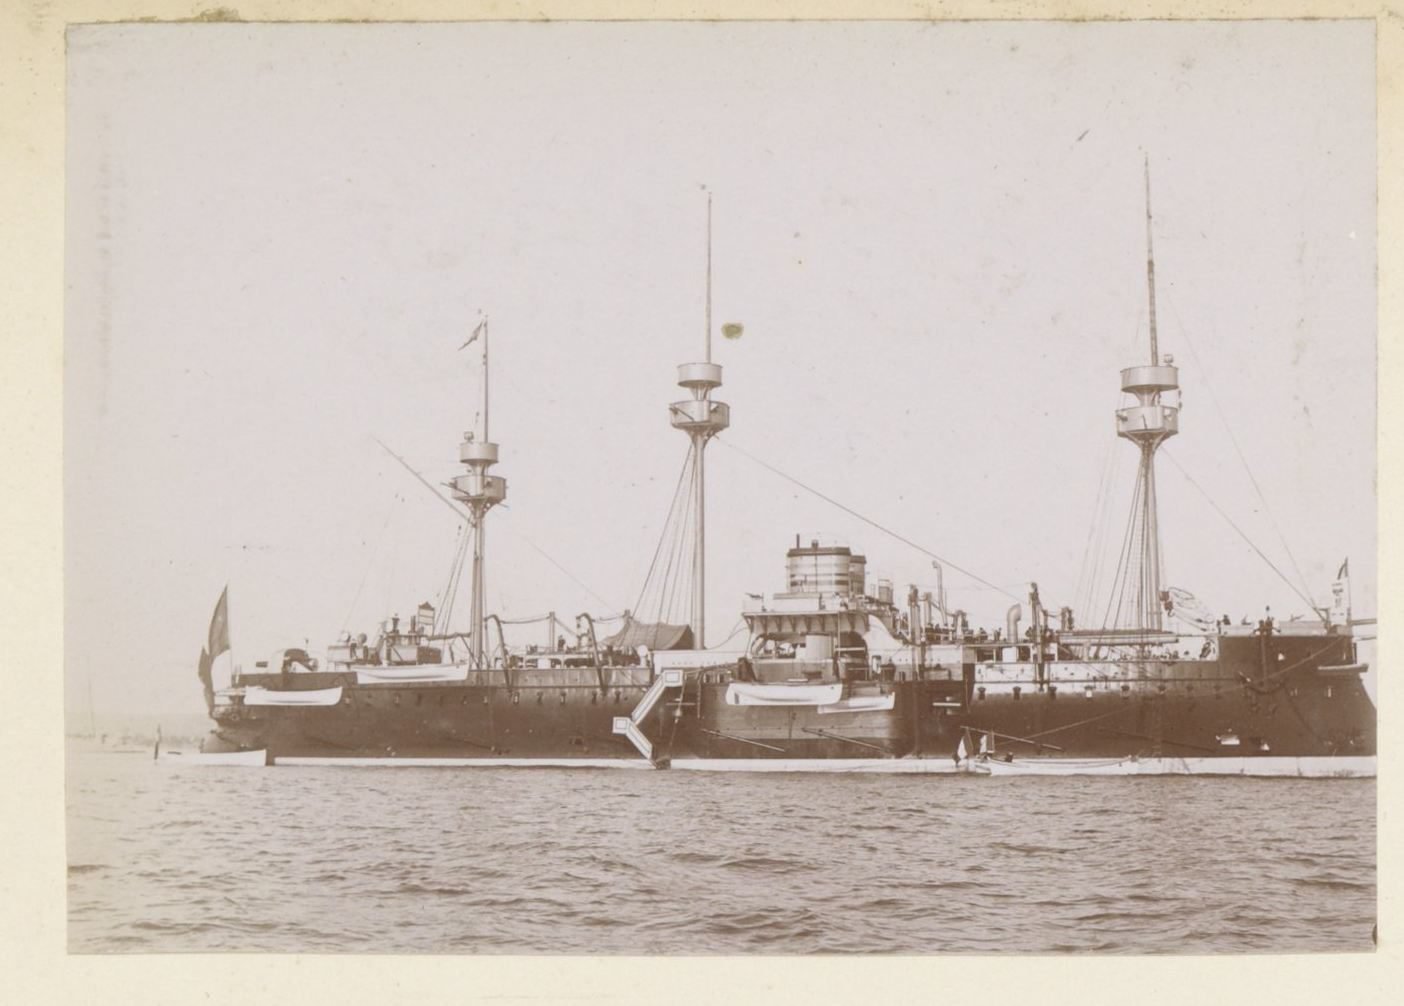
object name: photograph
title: Oorlogsschip, vermoedelijk Frans voor de kust van Zuid-Frankrijk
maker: Anonymous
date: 1900-1910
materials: paper, photographic support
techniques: daylight paper print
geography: southern france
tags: sailing-ship, sailing-boat (with name)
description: Onderdeel van Fotoalbum van een Franse amateurfotograaf met opnames van een familie, distilleerderij Delizy & Doistau Fils, het leger en bezienswaardigheden in Frankrijk.